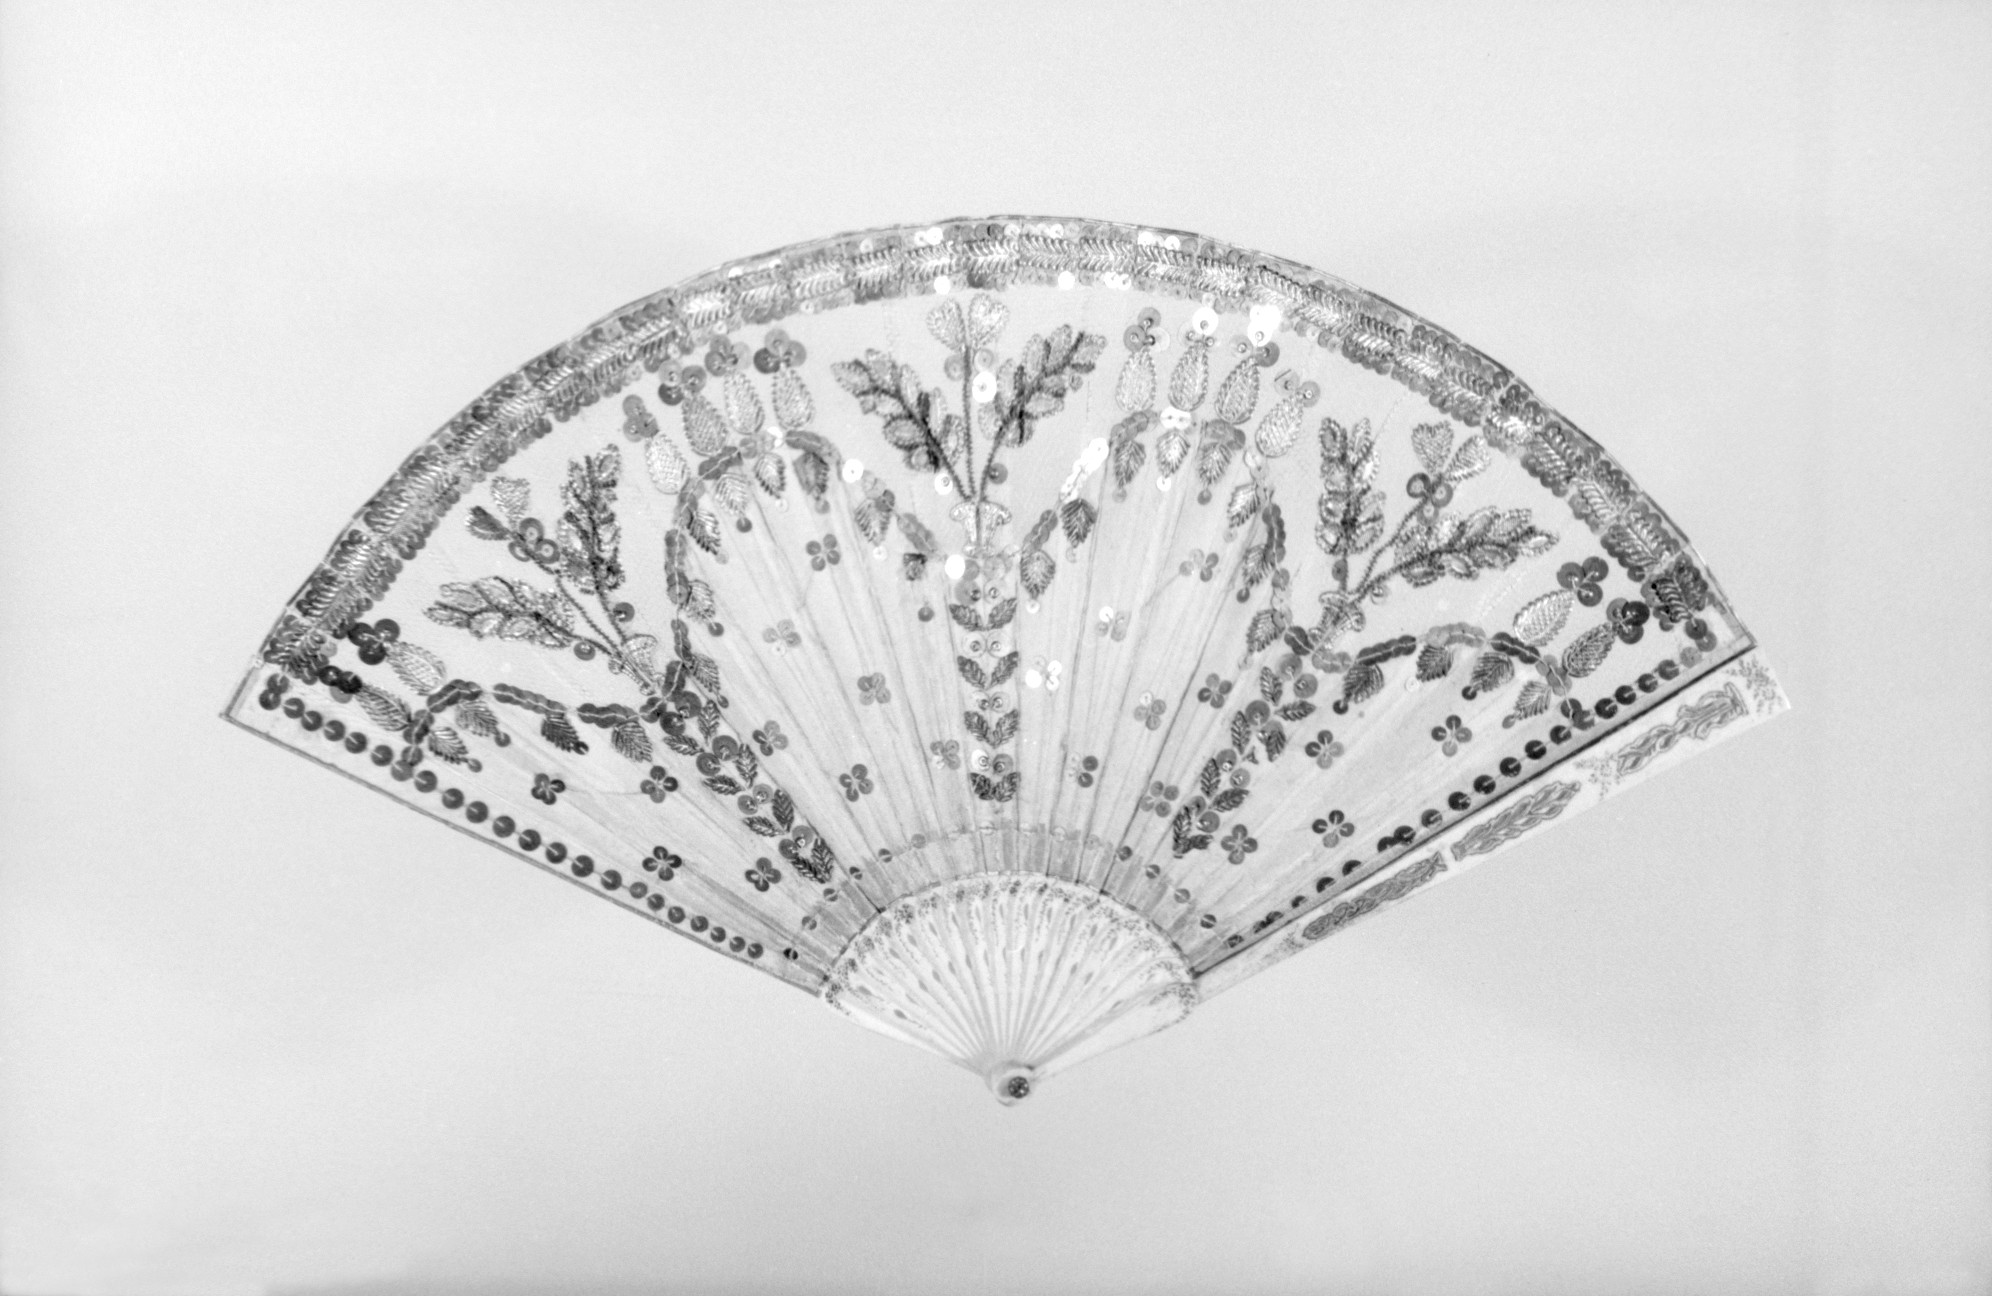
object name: fan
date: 1801-1833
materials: glass, ivory, paint, parchment, silk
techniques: gilding